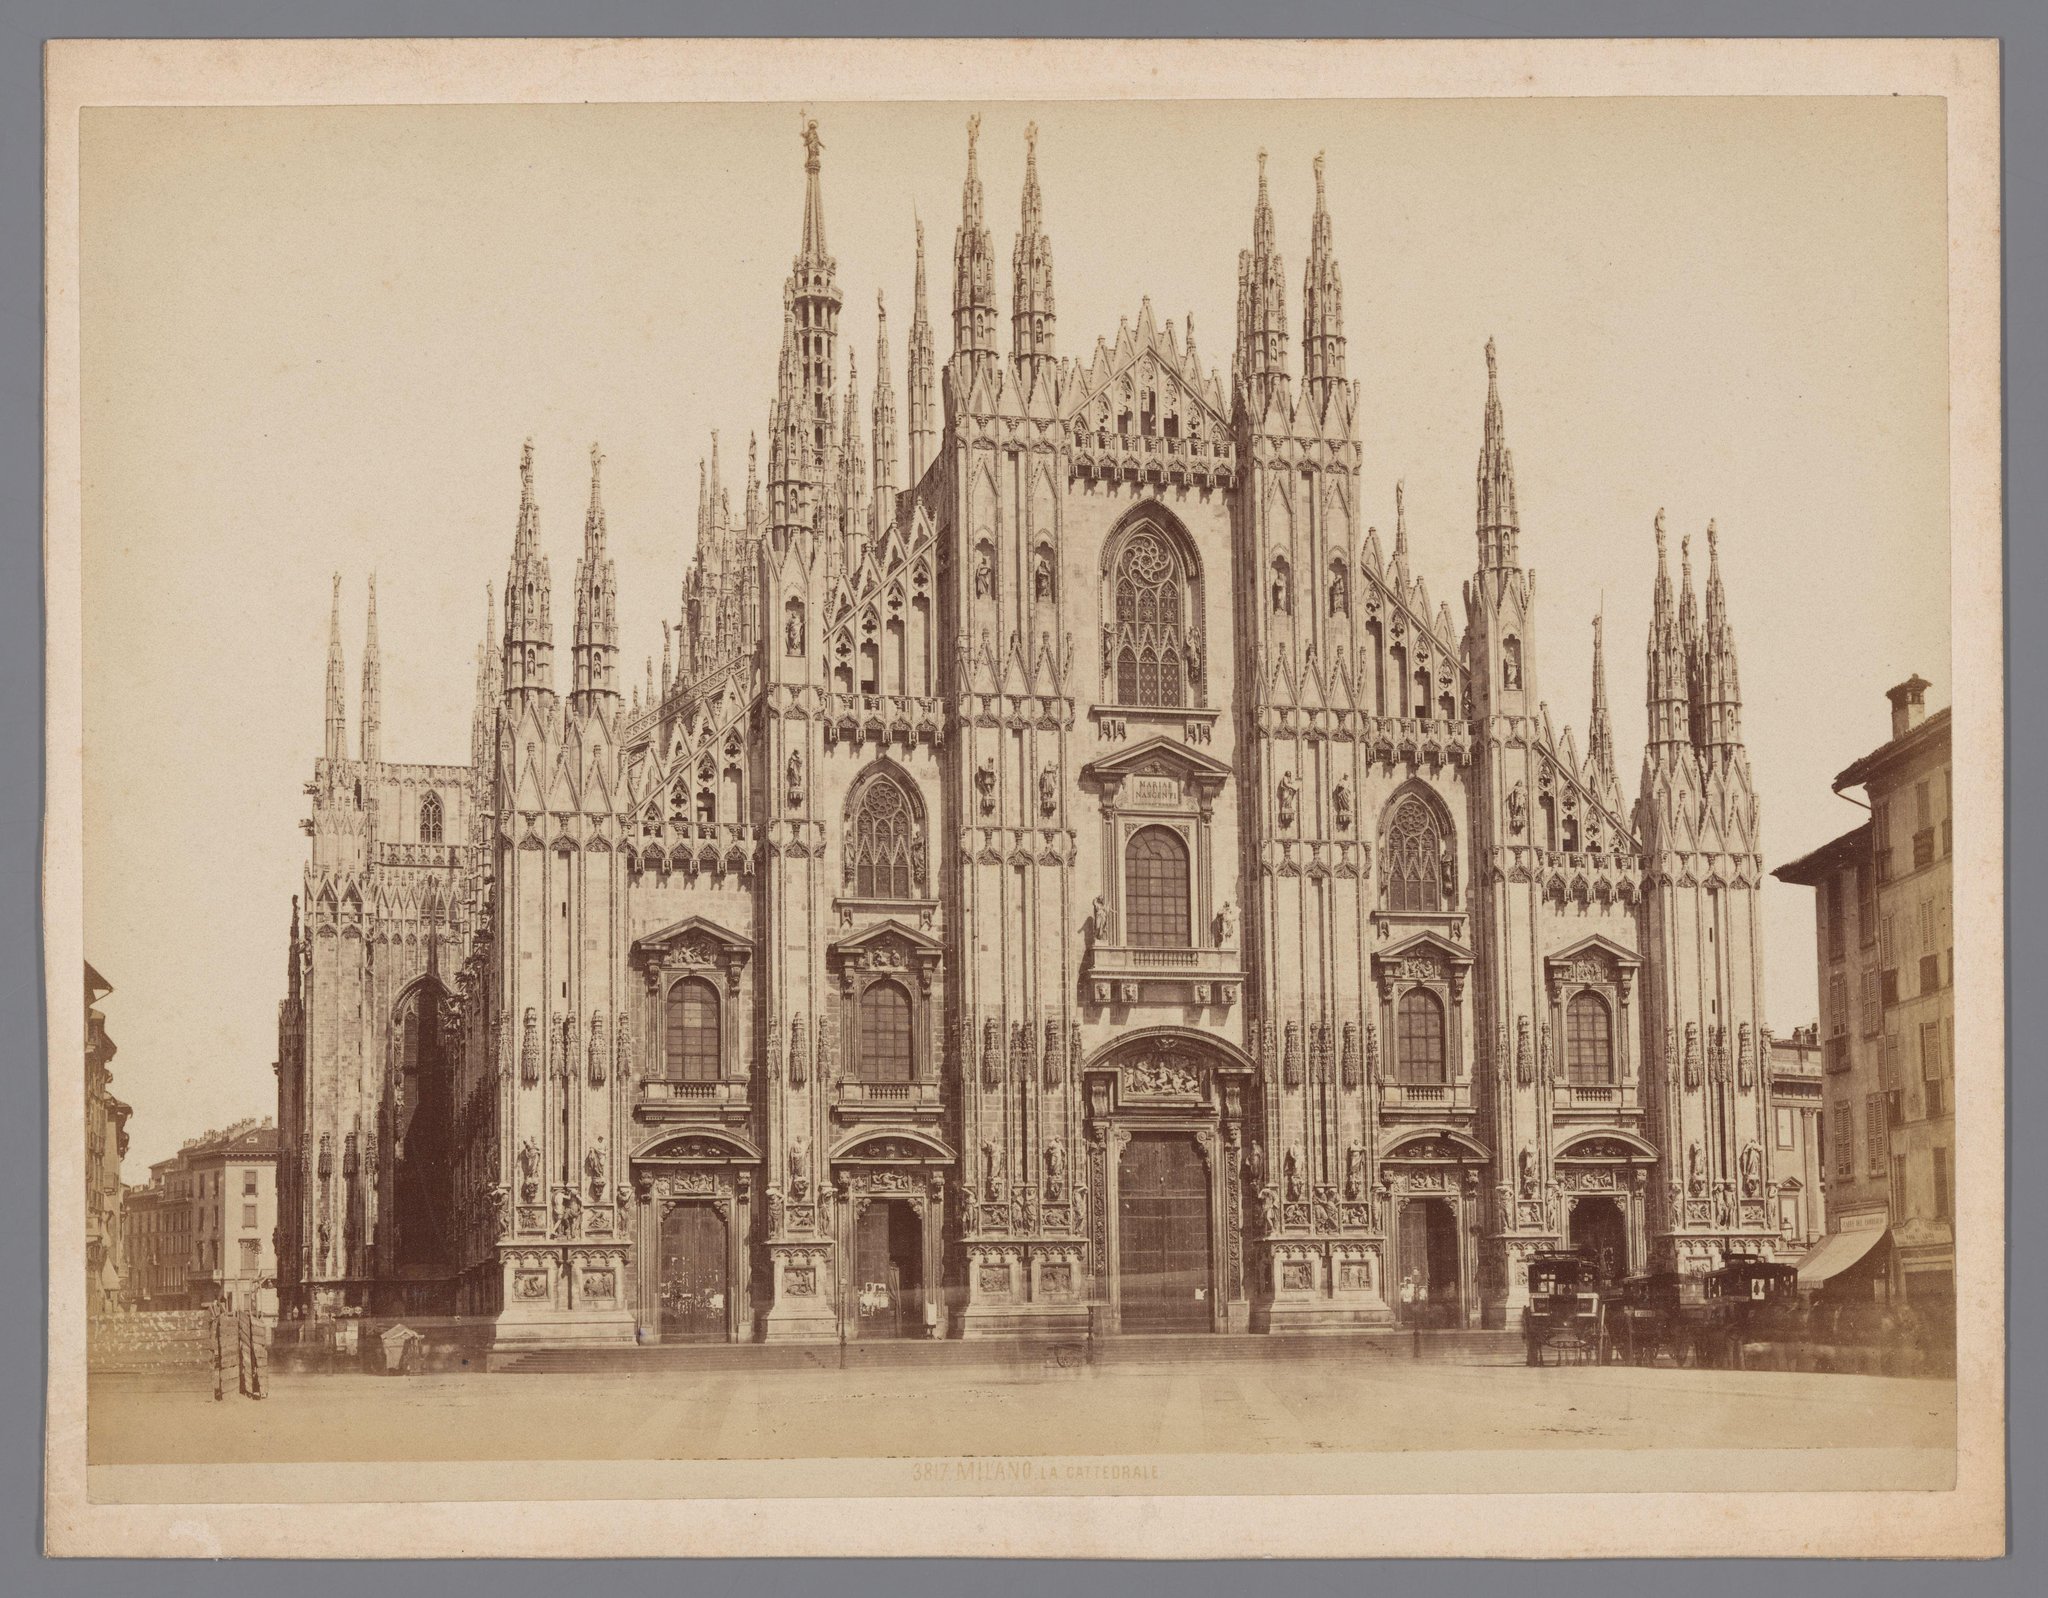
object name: photograph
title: La cattedrale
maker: Anonymous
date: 1851-1900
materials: cardboard, paper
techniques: albumen print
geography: milan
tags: parts of church exterior and annexes: west façade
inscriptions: number: ‘3817.’